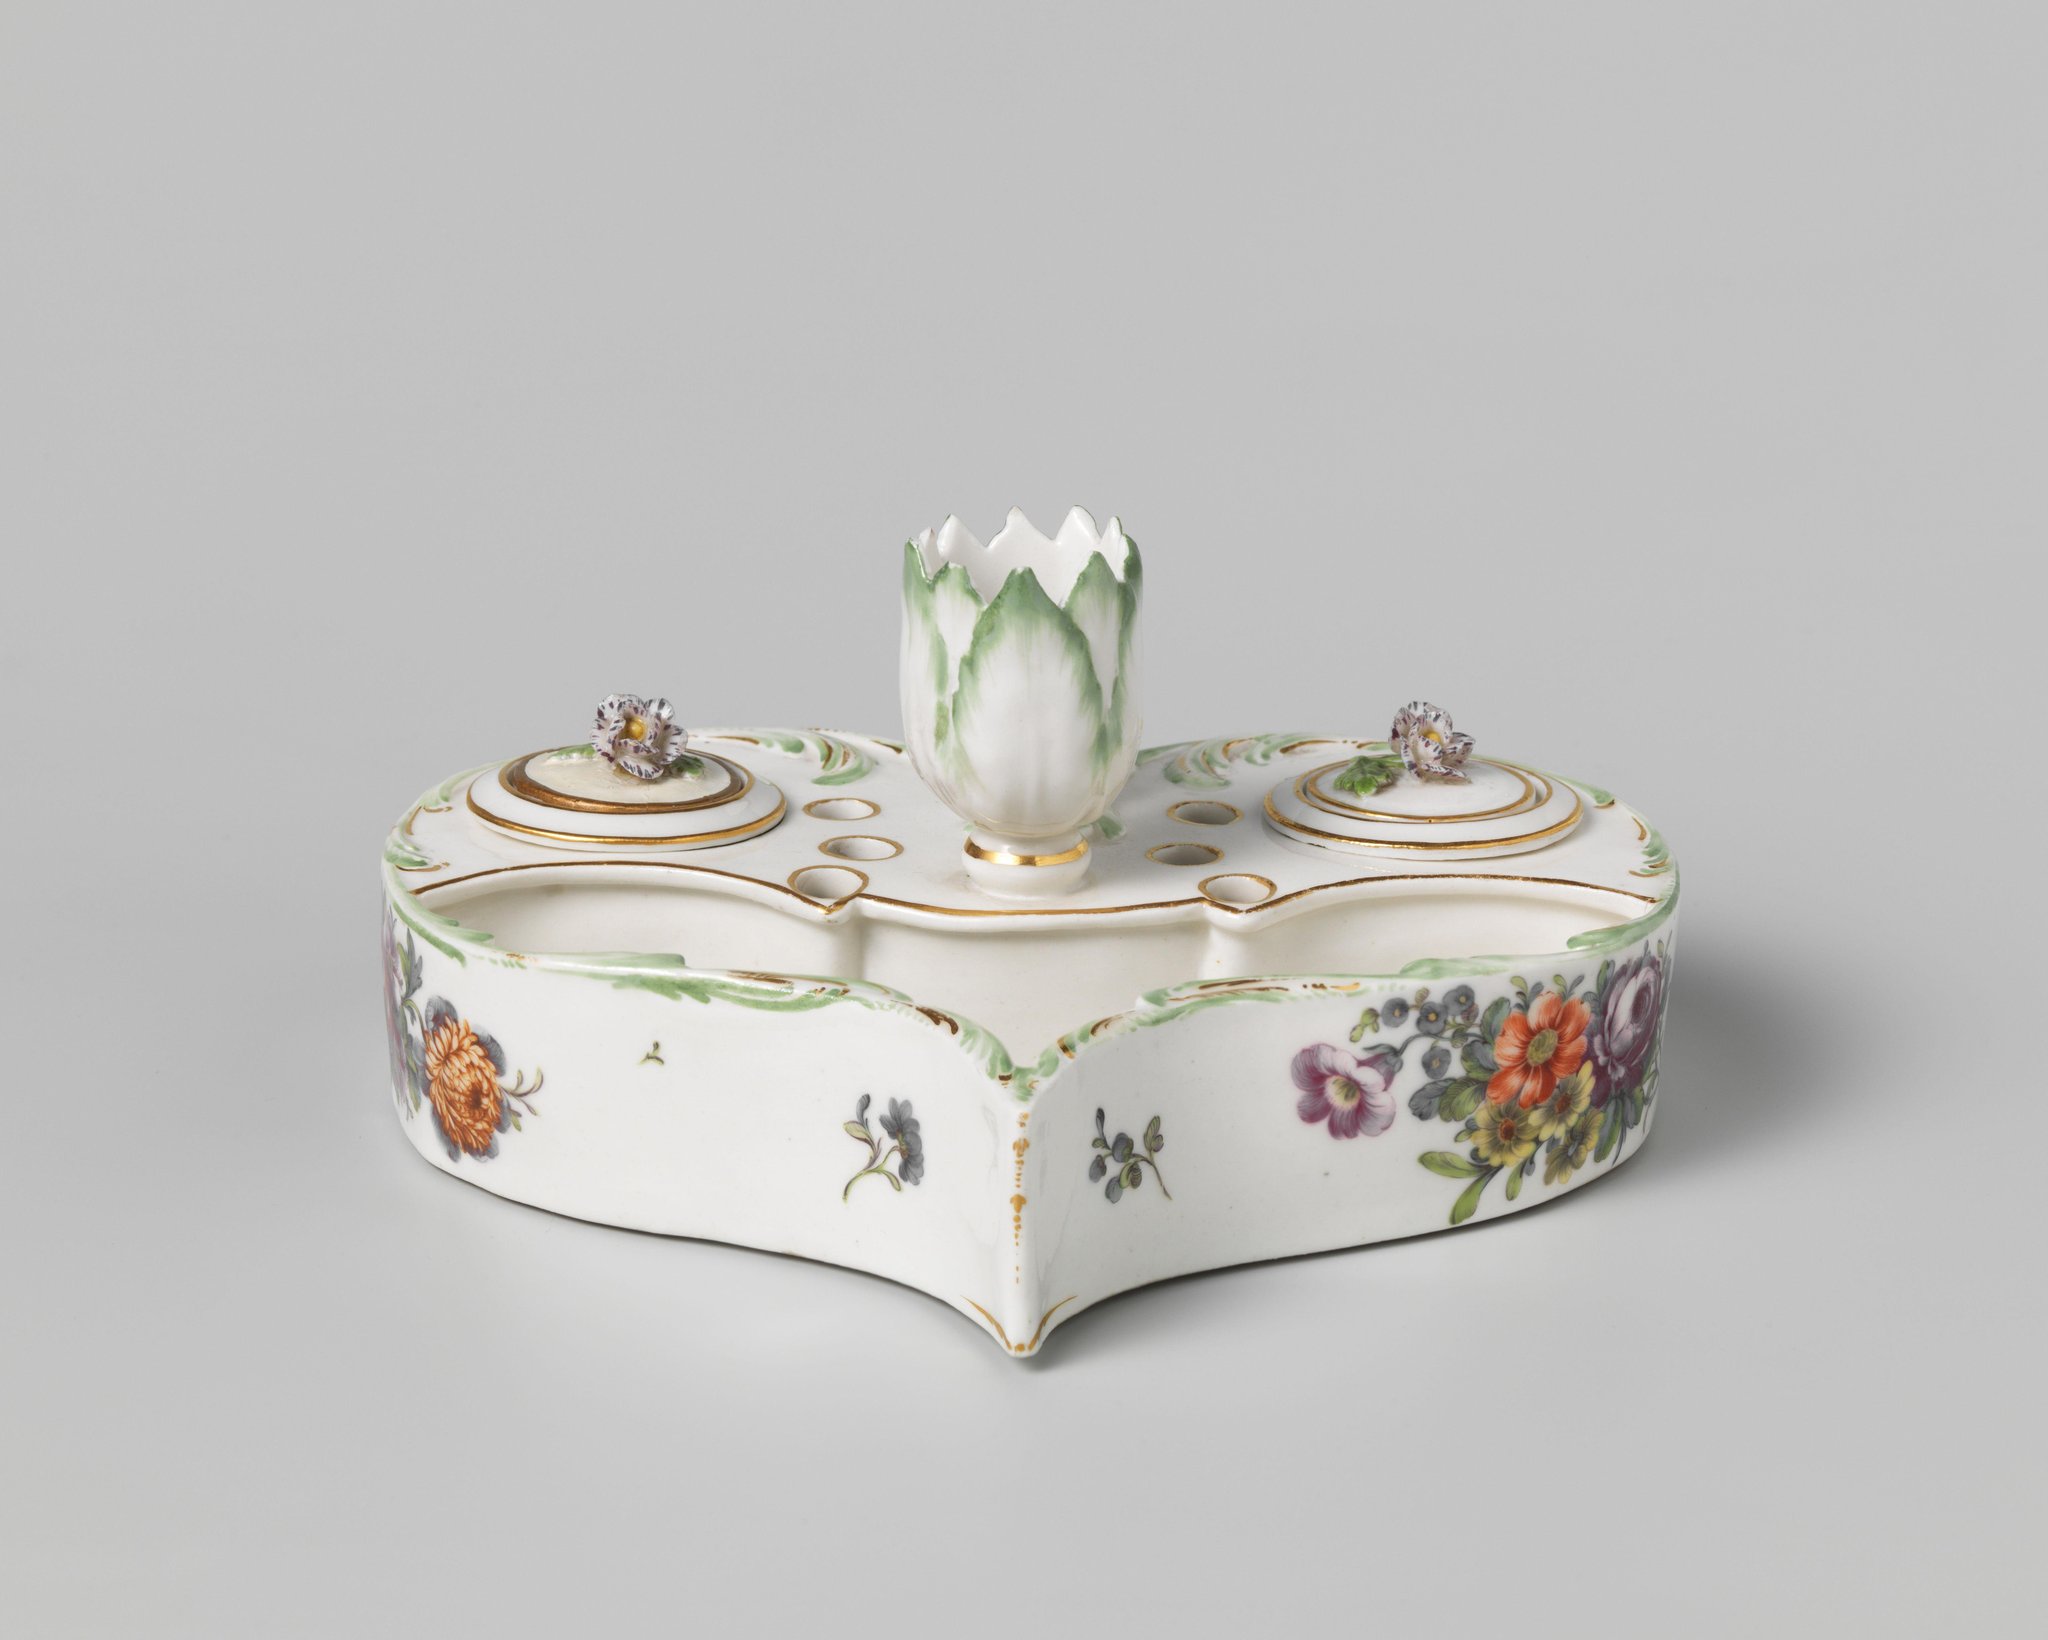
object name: inkstand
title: Inktstel, hartvormig, beschilderd met bloemboeketten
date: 1774-1778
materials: porcelain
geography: loosdrecht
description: Inktstel van porselein. Hartvormig, met rocailles in groen en goud op de rand. De kaarsehouder (in de vorm van een bloemkelk) en het oor (in de vorm van een tak met bladeren) zijn eveneens versierd in groen en goud. In het gesloten deel twee ronde uitsparingen voor een inktpot en een zandstrooier, beide met dekseltje, waarop een plastische bloem aan een takje met bladeren in groen, geel en paars, en zes gaten voor pennen. Op de wand twee grote veelkleurige bloemboeketten en enkele losse bloemtakjes. Gouden biezen langs de randen van inktpot en zandstrooier en hun dekseltjes.